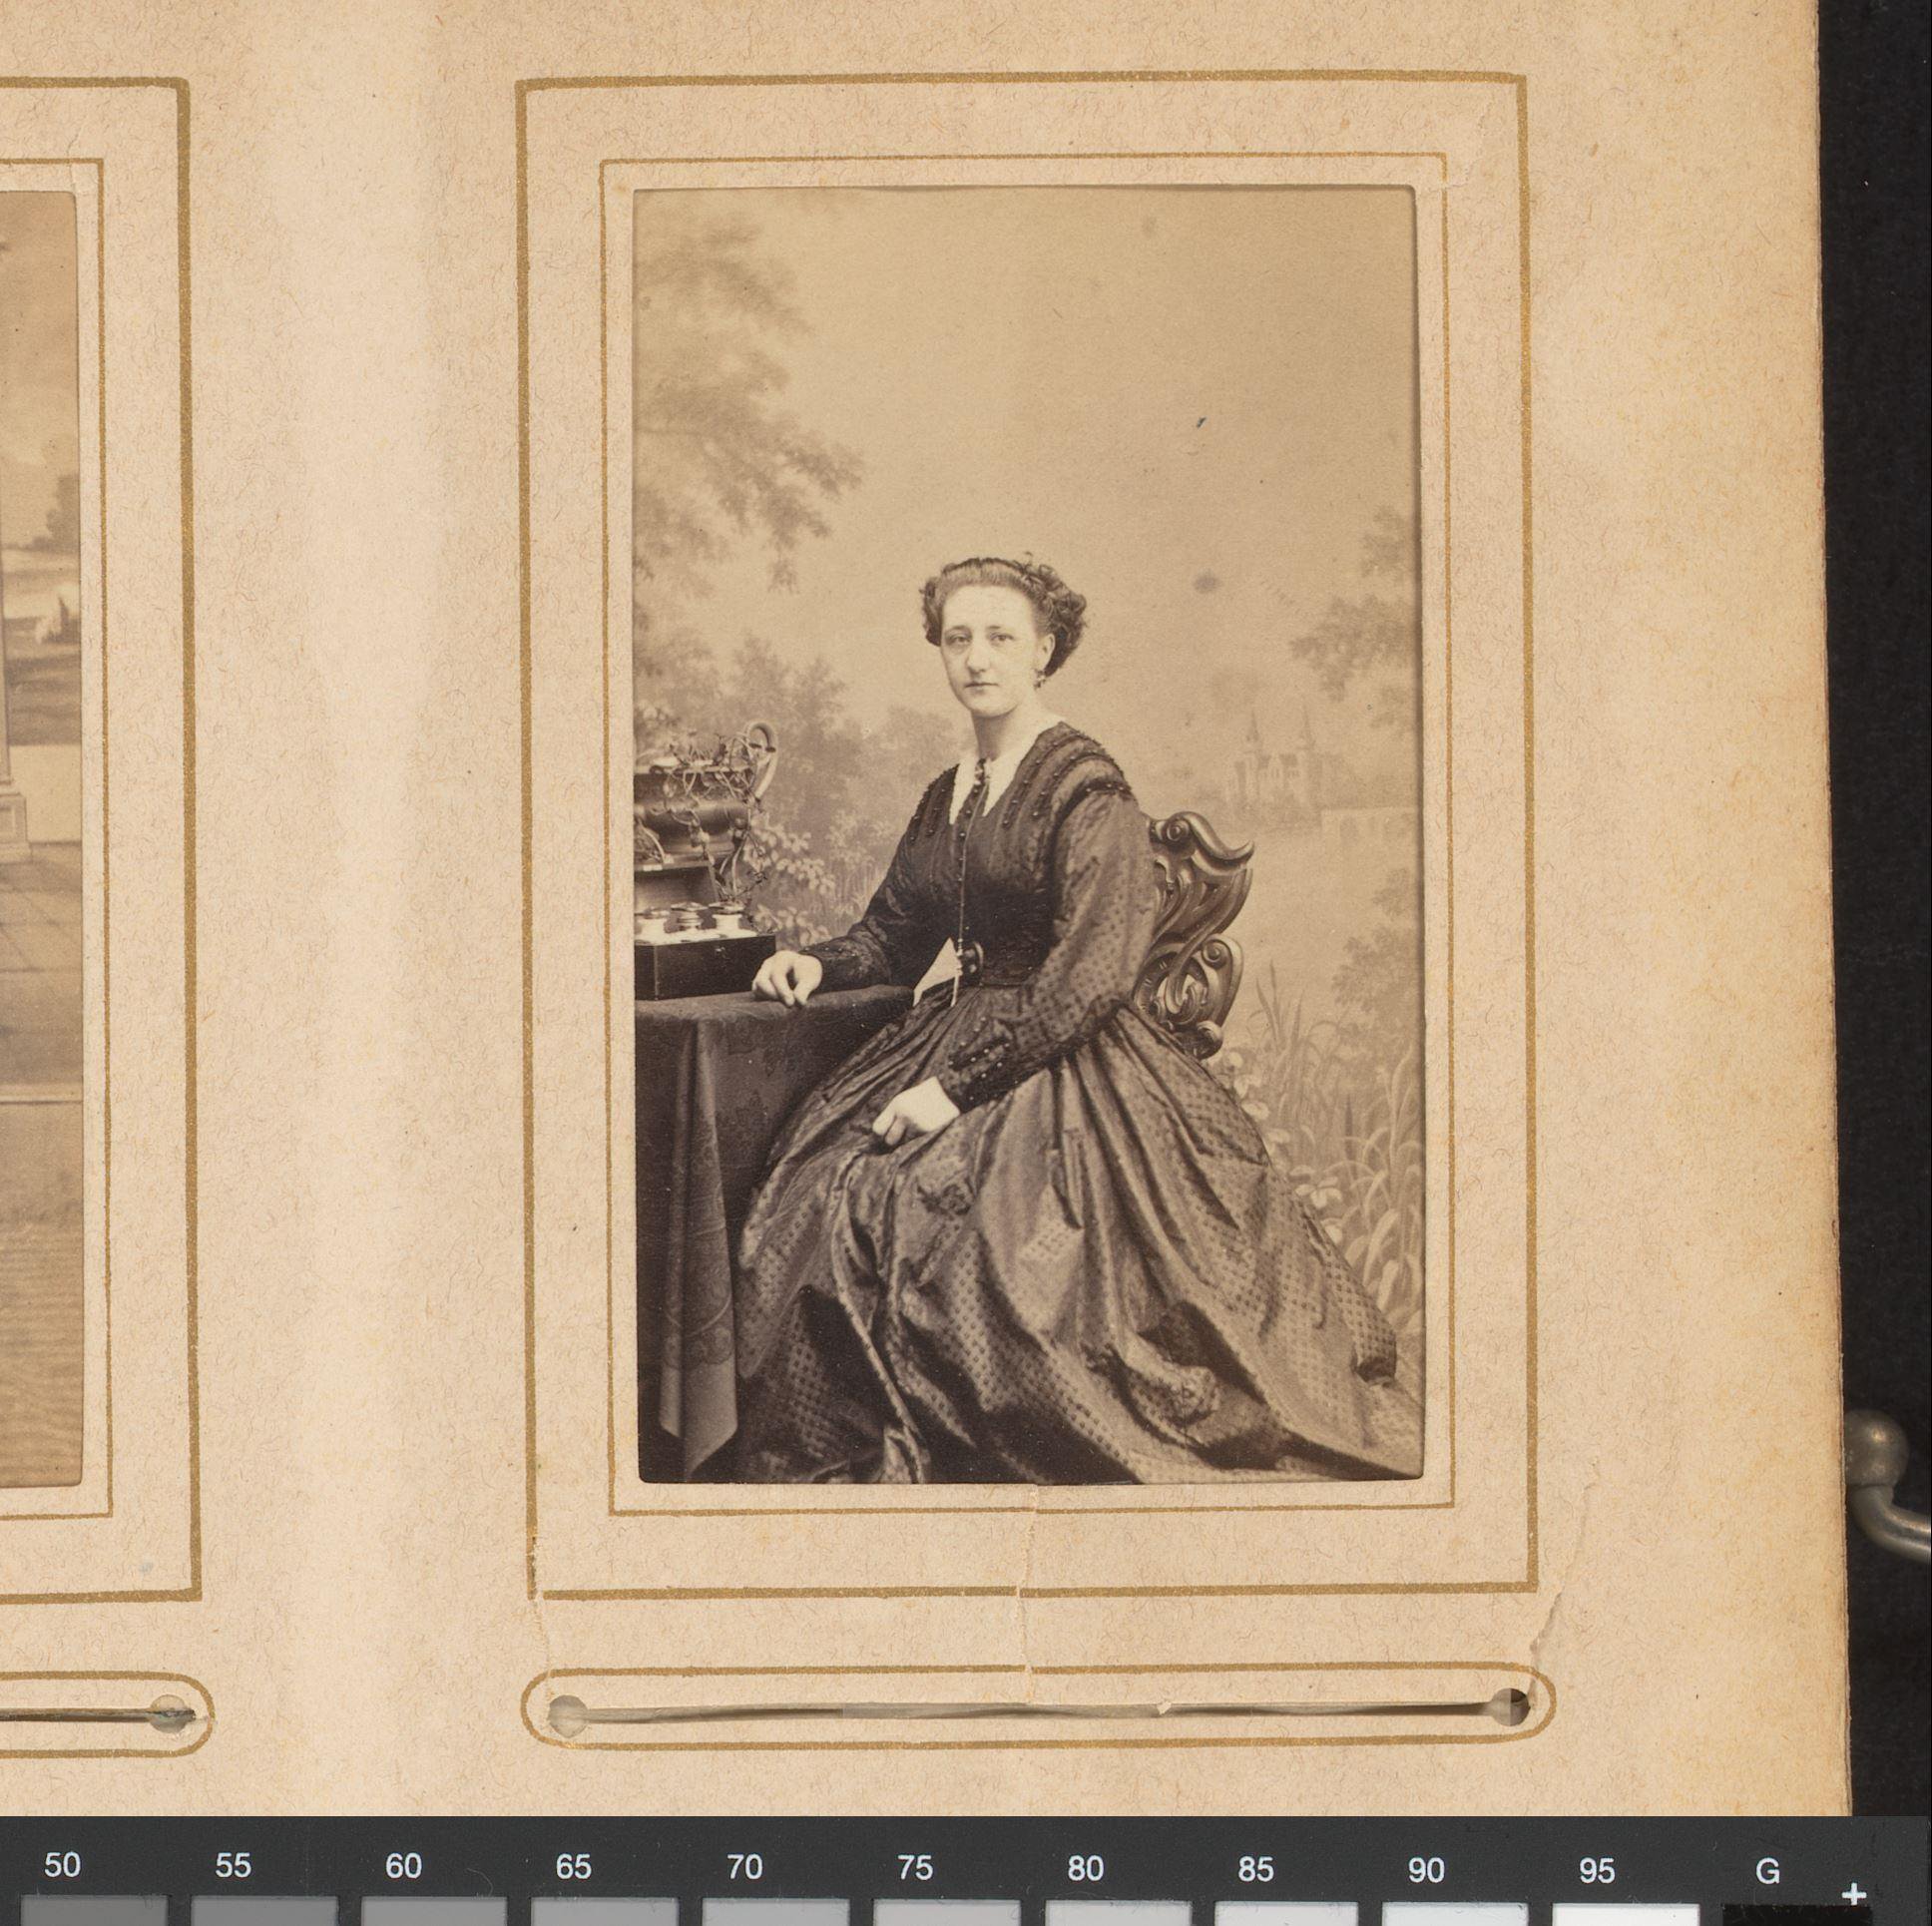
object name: carte de visite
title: Portret van een vrouw, zittend aan een tafel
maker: Anonymous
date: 1860-1890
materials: cardboard, photographic support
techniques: albumen print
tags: sitting figure - aa - female human figure, historical persons - bb - woman